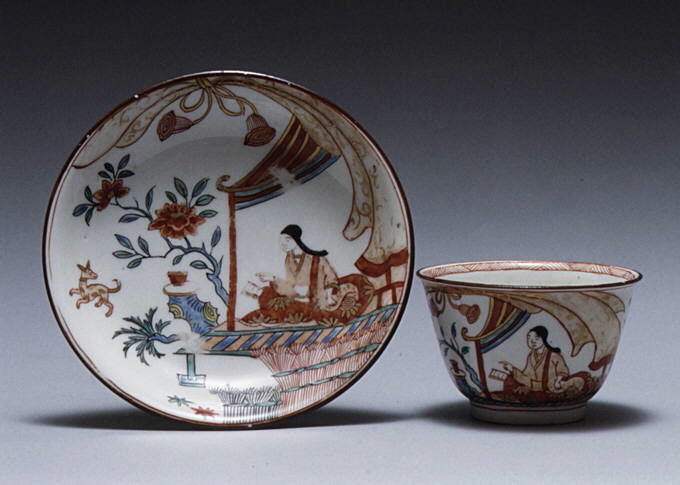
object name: teabowl and saucer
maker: meissen manufactory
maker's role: manufactory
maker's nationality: german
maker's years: 1710-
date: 1740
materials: hard paste porcelain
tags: women,dogs,flowers